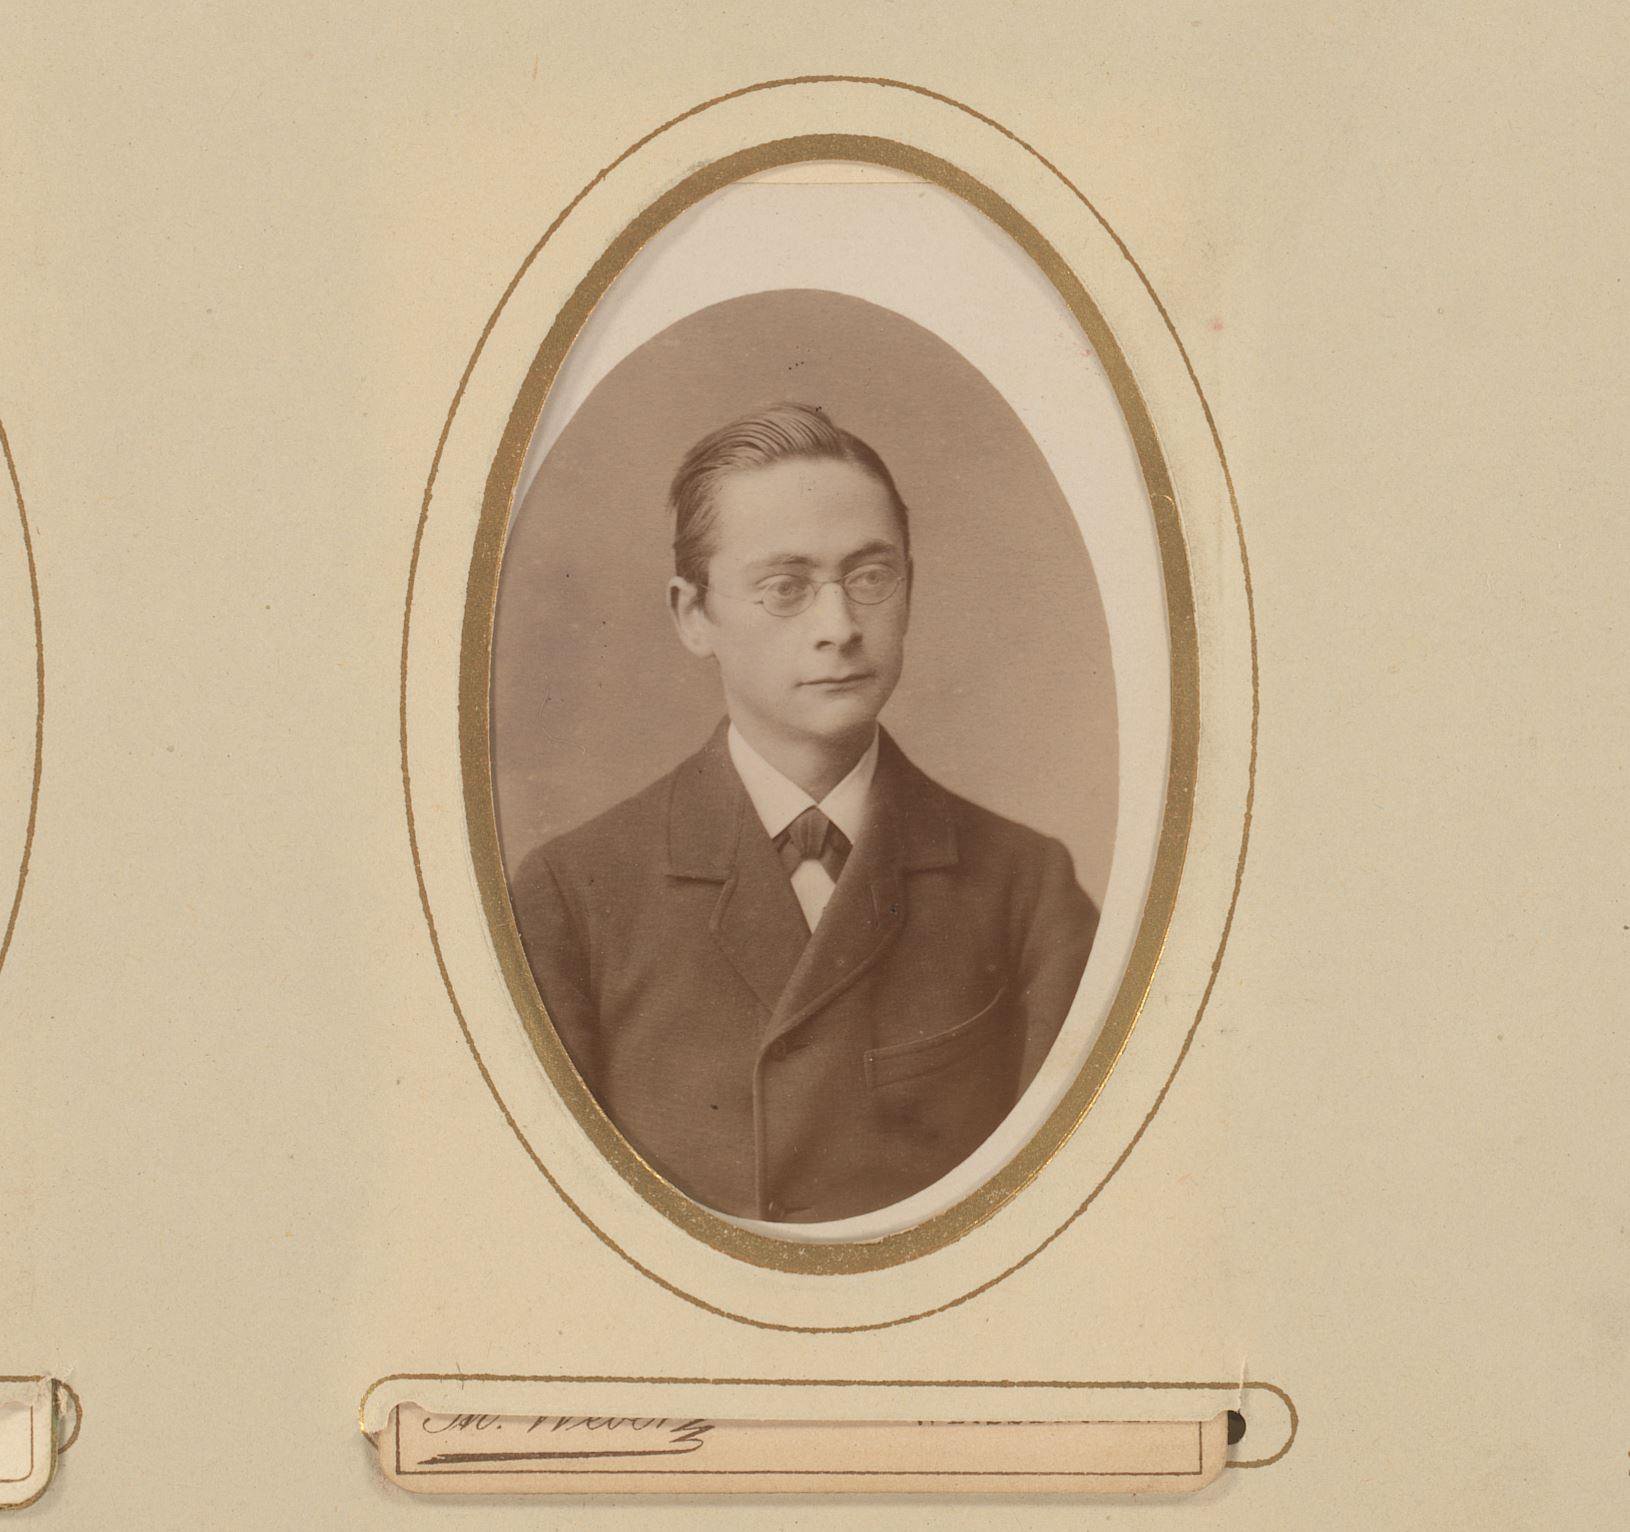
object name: photograph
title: Portret van een jonge man met bril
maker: theodor weber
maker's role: fotograaf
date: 1850-1900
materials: cardboard, photographic support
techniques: albumen print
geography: weissenfels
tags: eyeglasses, spectacles, historical persons, youth, adolescent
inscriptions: inscription: ‘Th. Weber/ Weissenfels/ Promenade 33./ Die Platten bleiben für Nachbestellungen aufbewahrt und können jederzeit/ Abzüge sowie Vergrösserungen davon geliefert werden.’